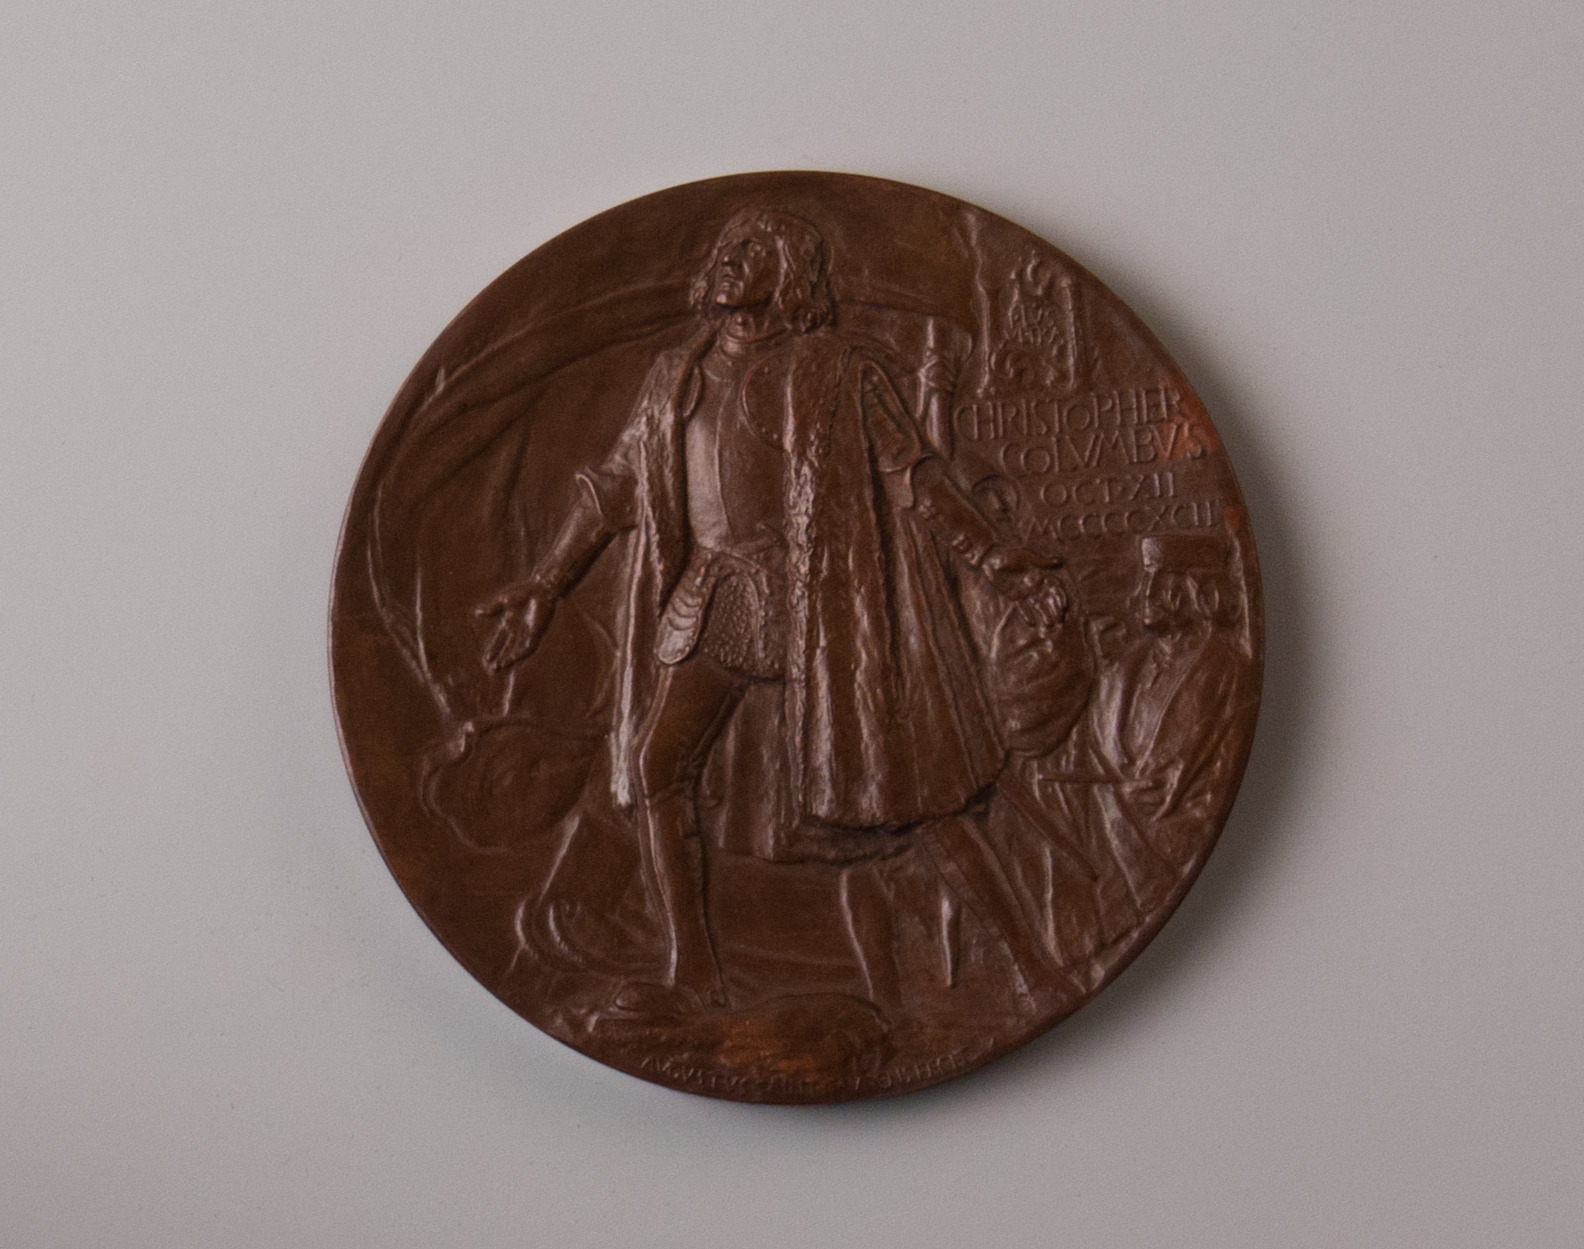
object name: medal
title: World’s Columbian Exposition Commemorative Presentation Medal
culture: american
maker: augustus saint-gaudens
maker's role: artist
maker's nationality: american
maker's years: 1848-1907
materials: bronze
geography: united states